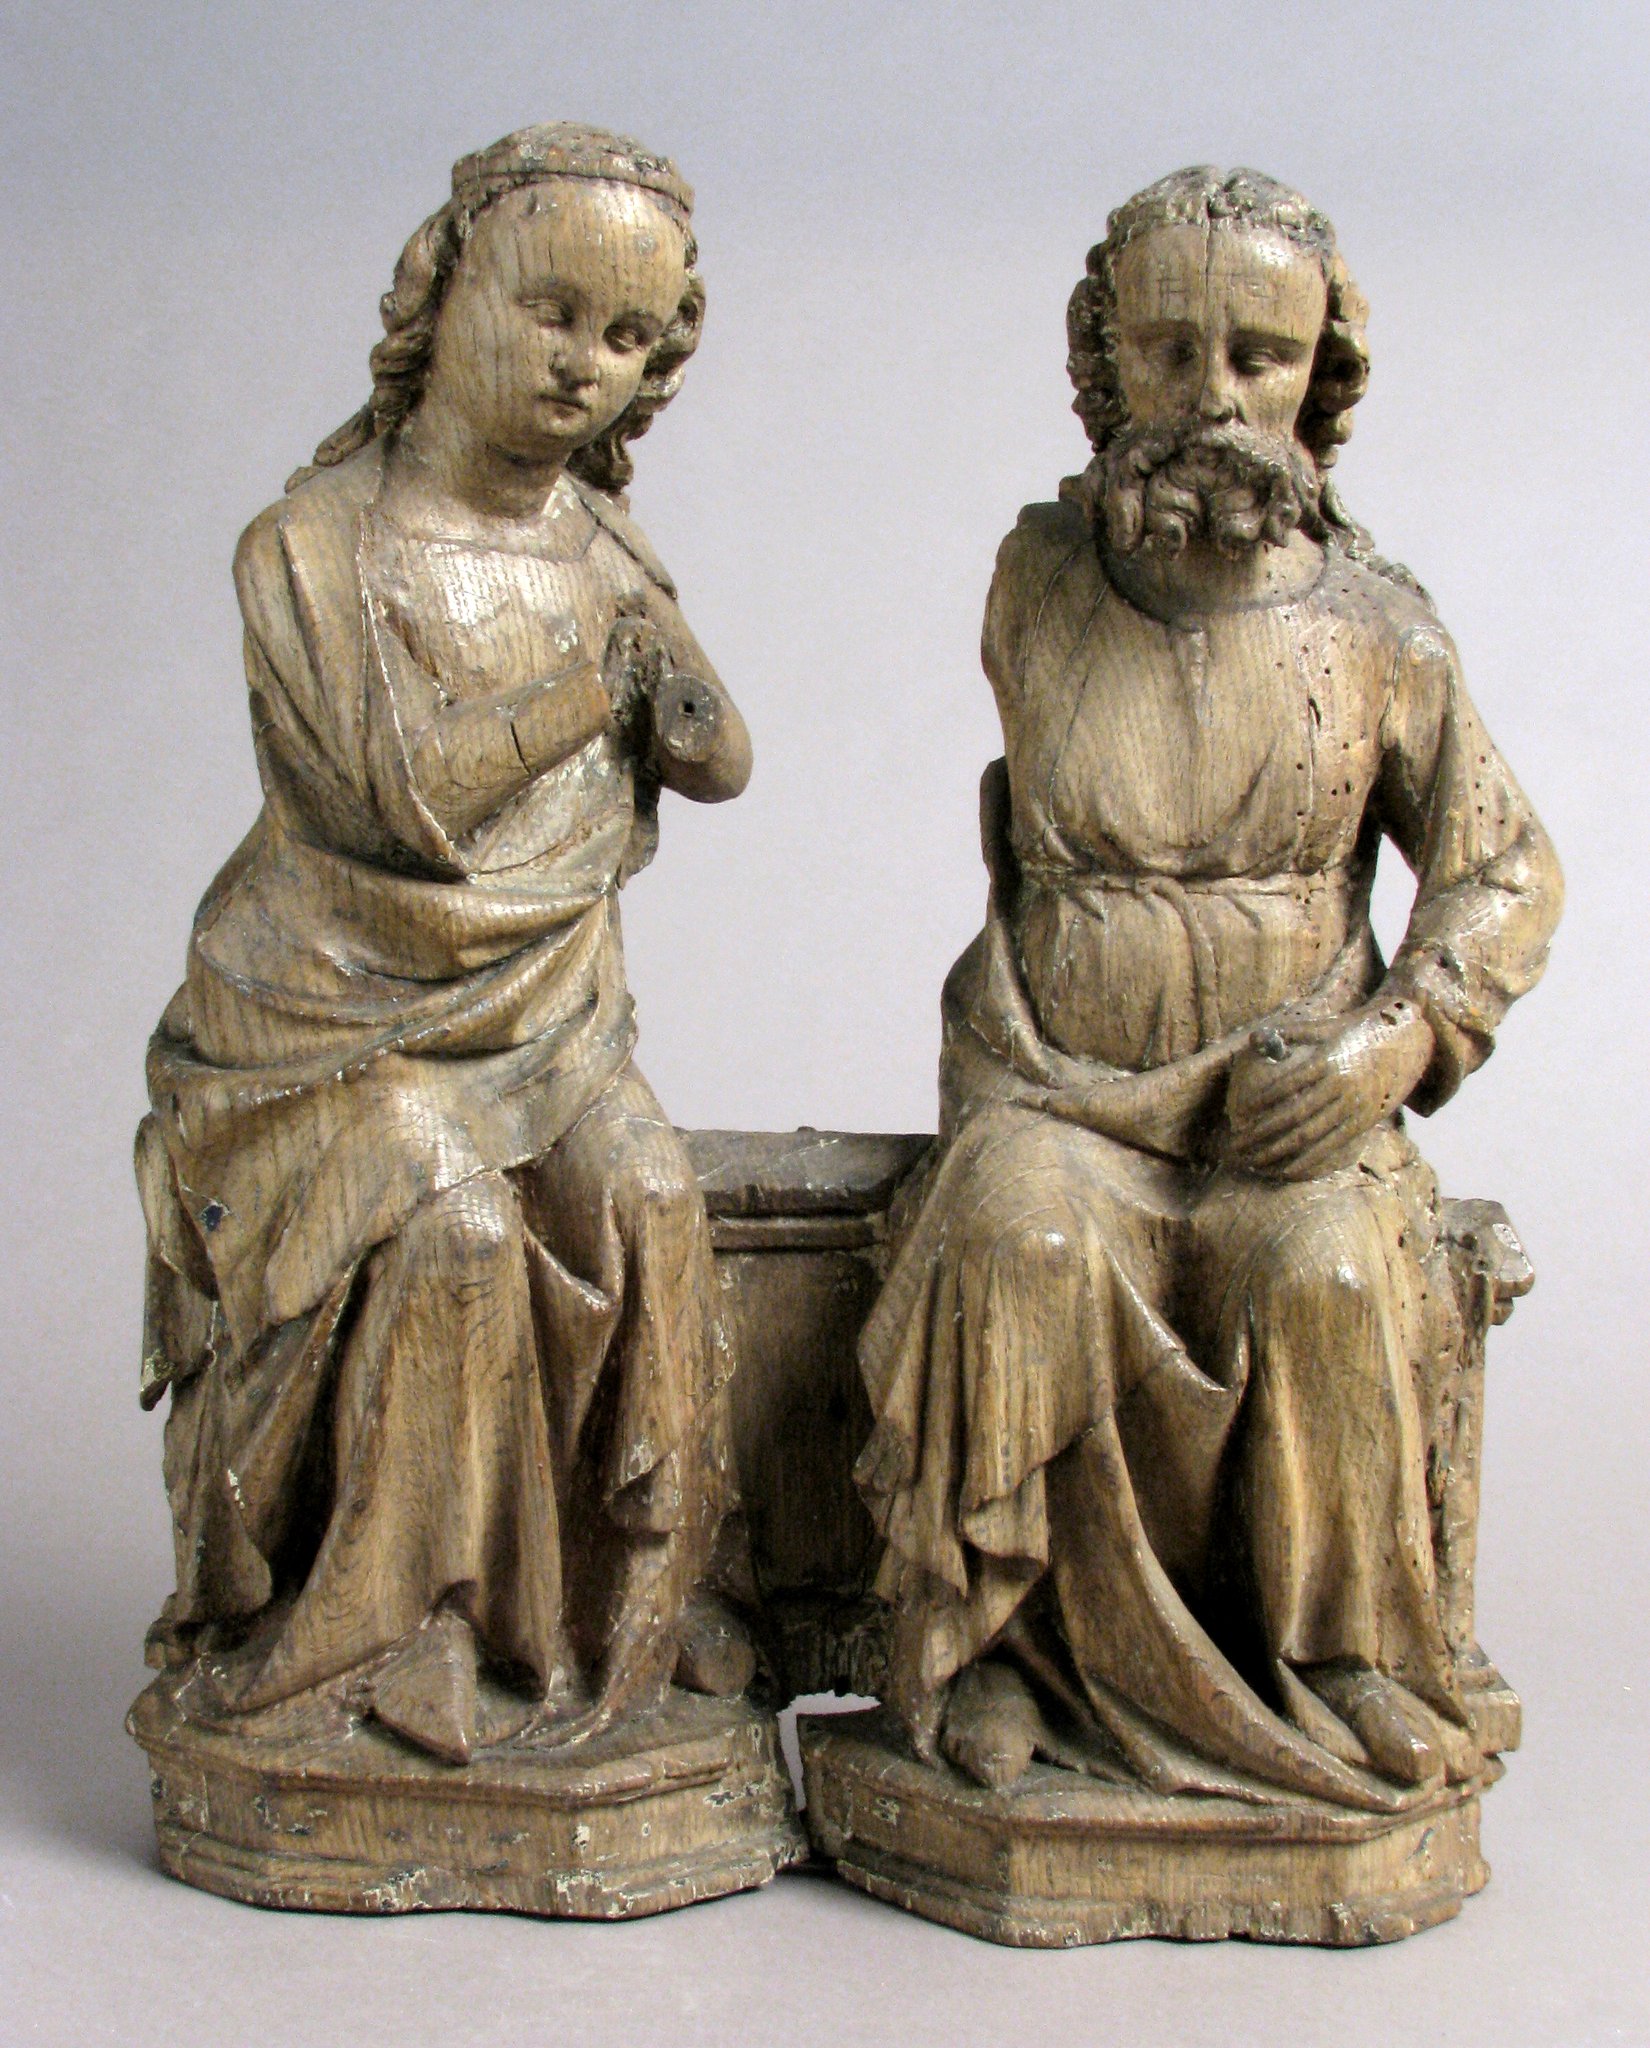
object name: statuette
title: Coronation of the Virgin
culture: german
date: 1330-1340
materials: wood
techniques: polychromy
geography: germany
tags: christ